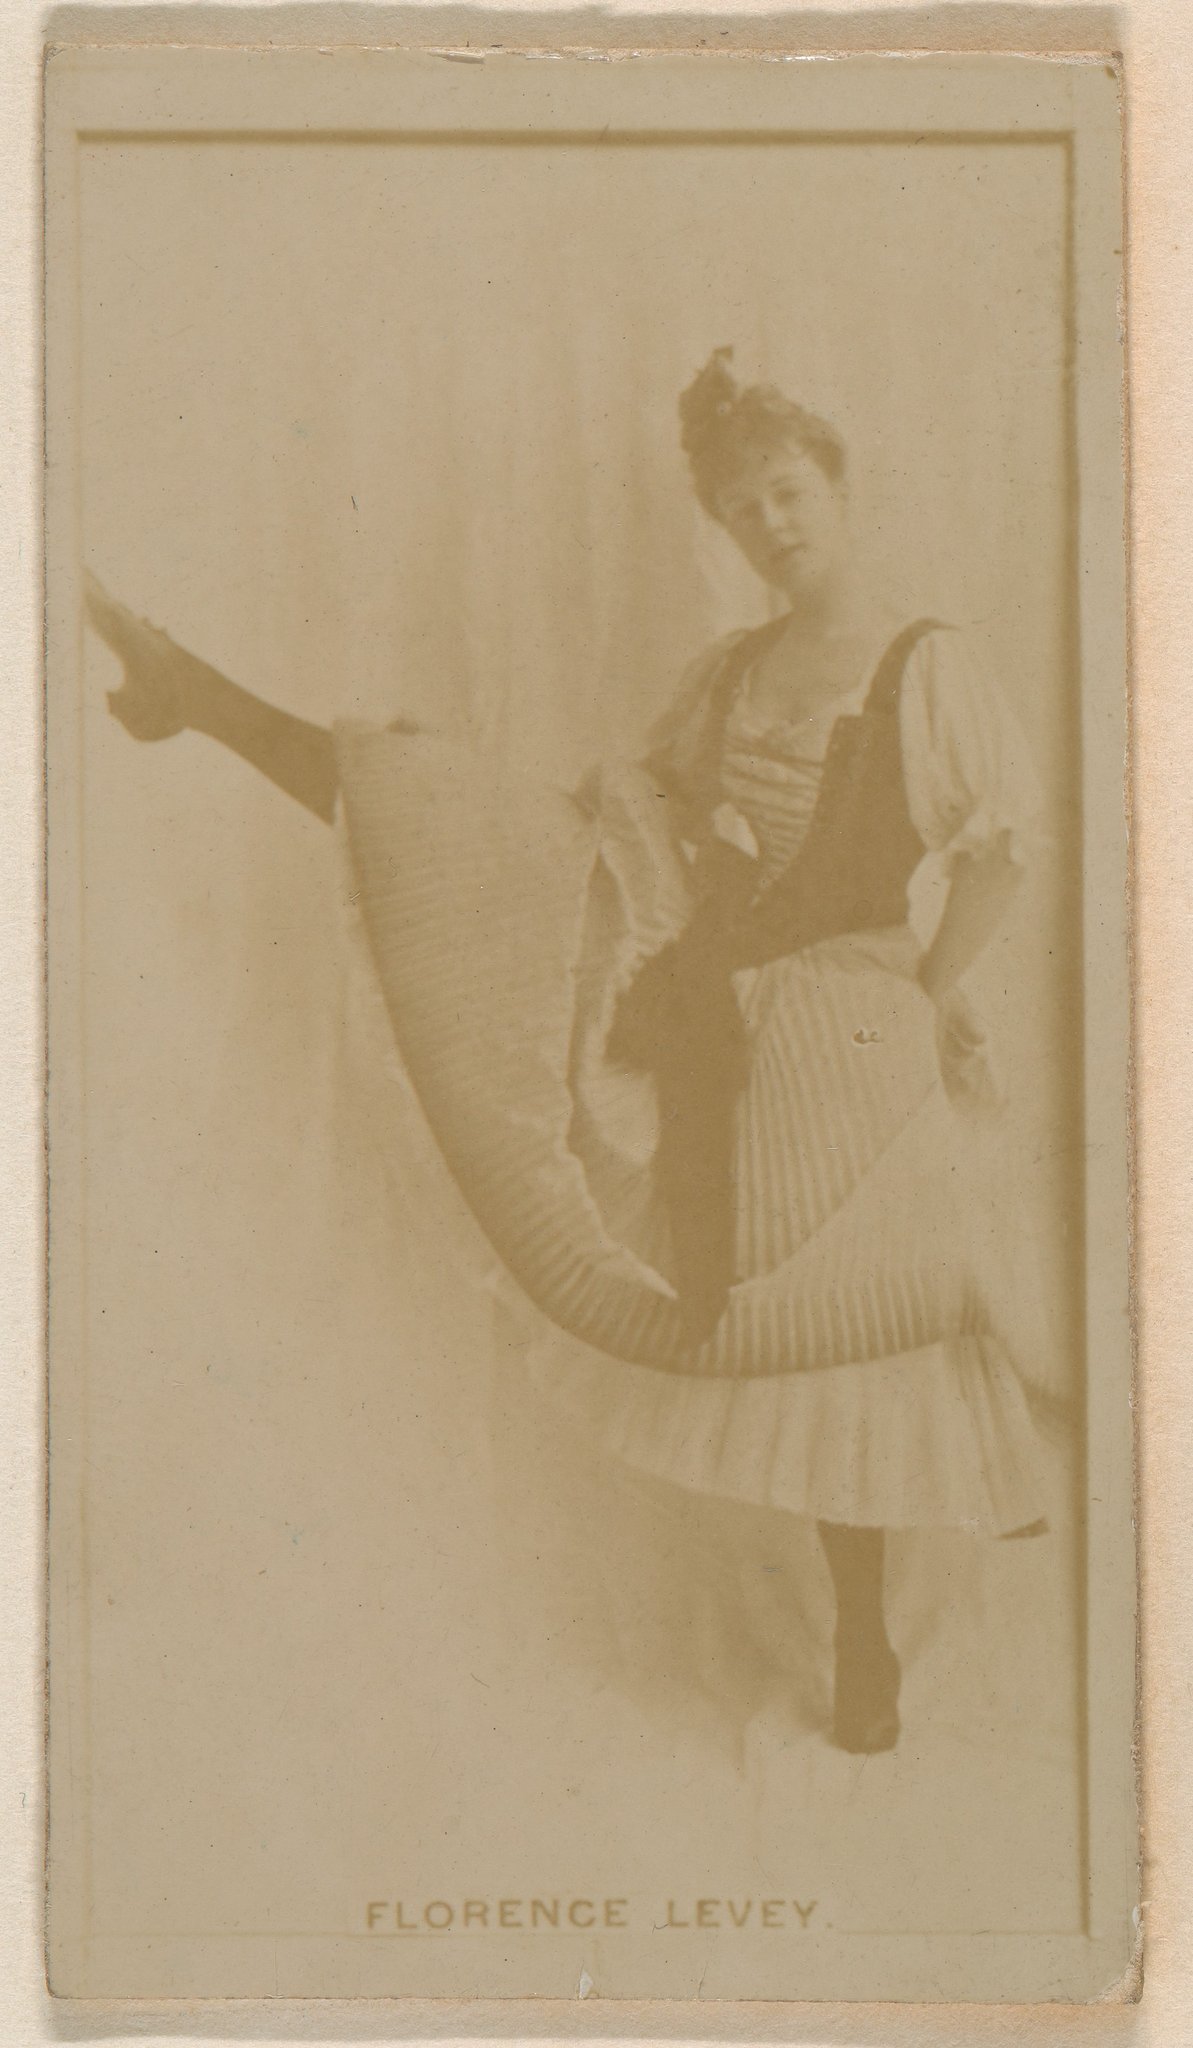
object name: photograph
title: Florence Levey, from the Actresses series (N245) issued by Kinney Brothers to promote Sweet Caporal Cigarettes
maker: kinney brothers tobacco company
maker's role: publisher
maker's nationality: american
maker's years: 1869-2011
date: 1890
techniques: albumen silver print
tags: portraits,women,actresses